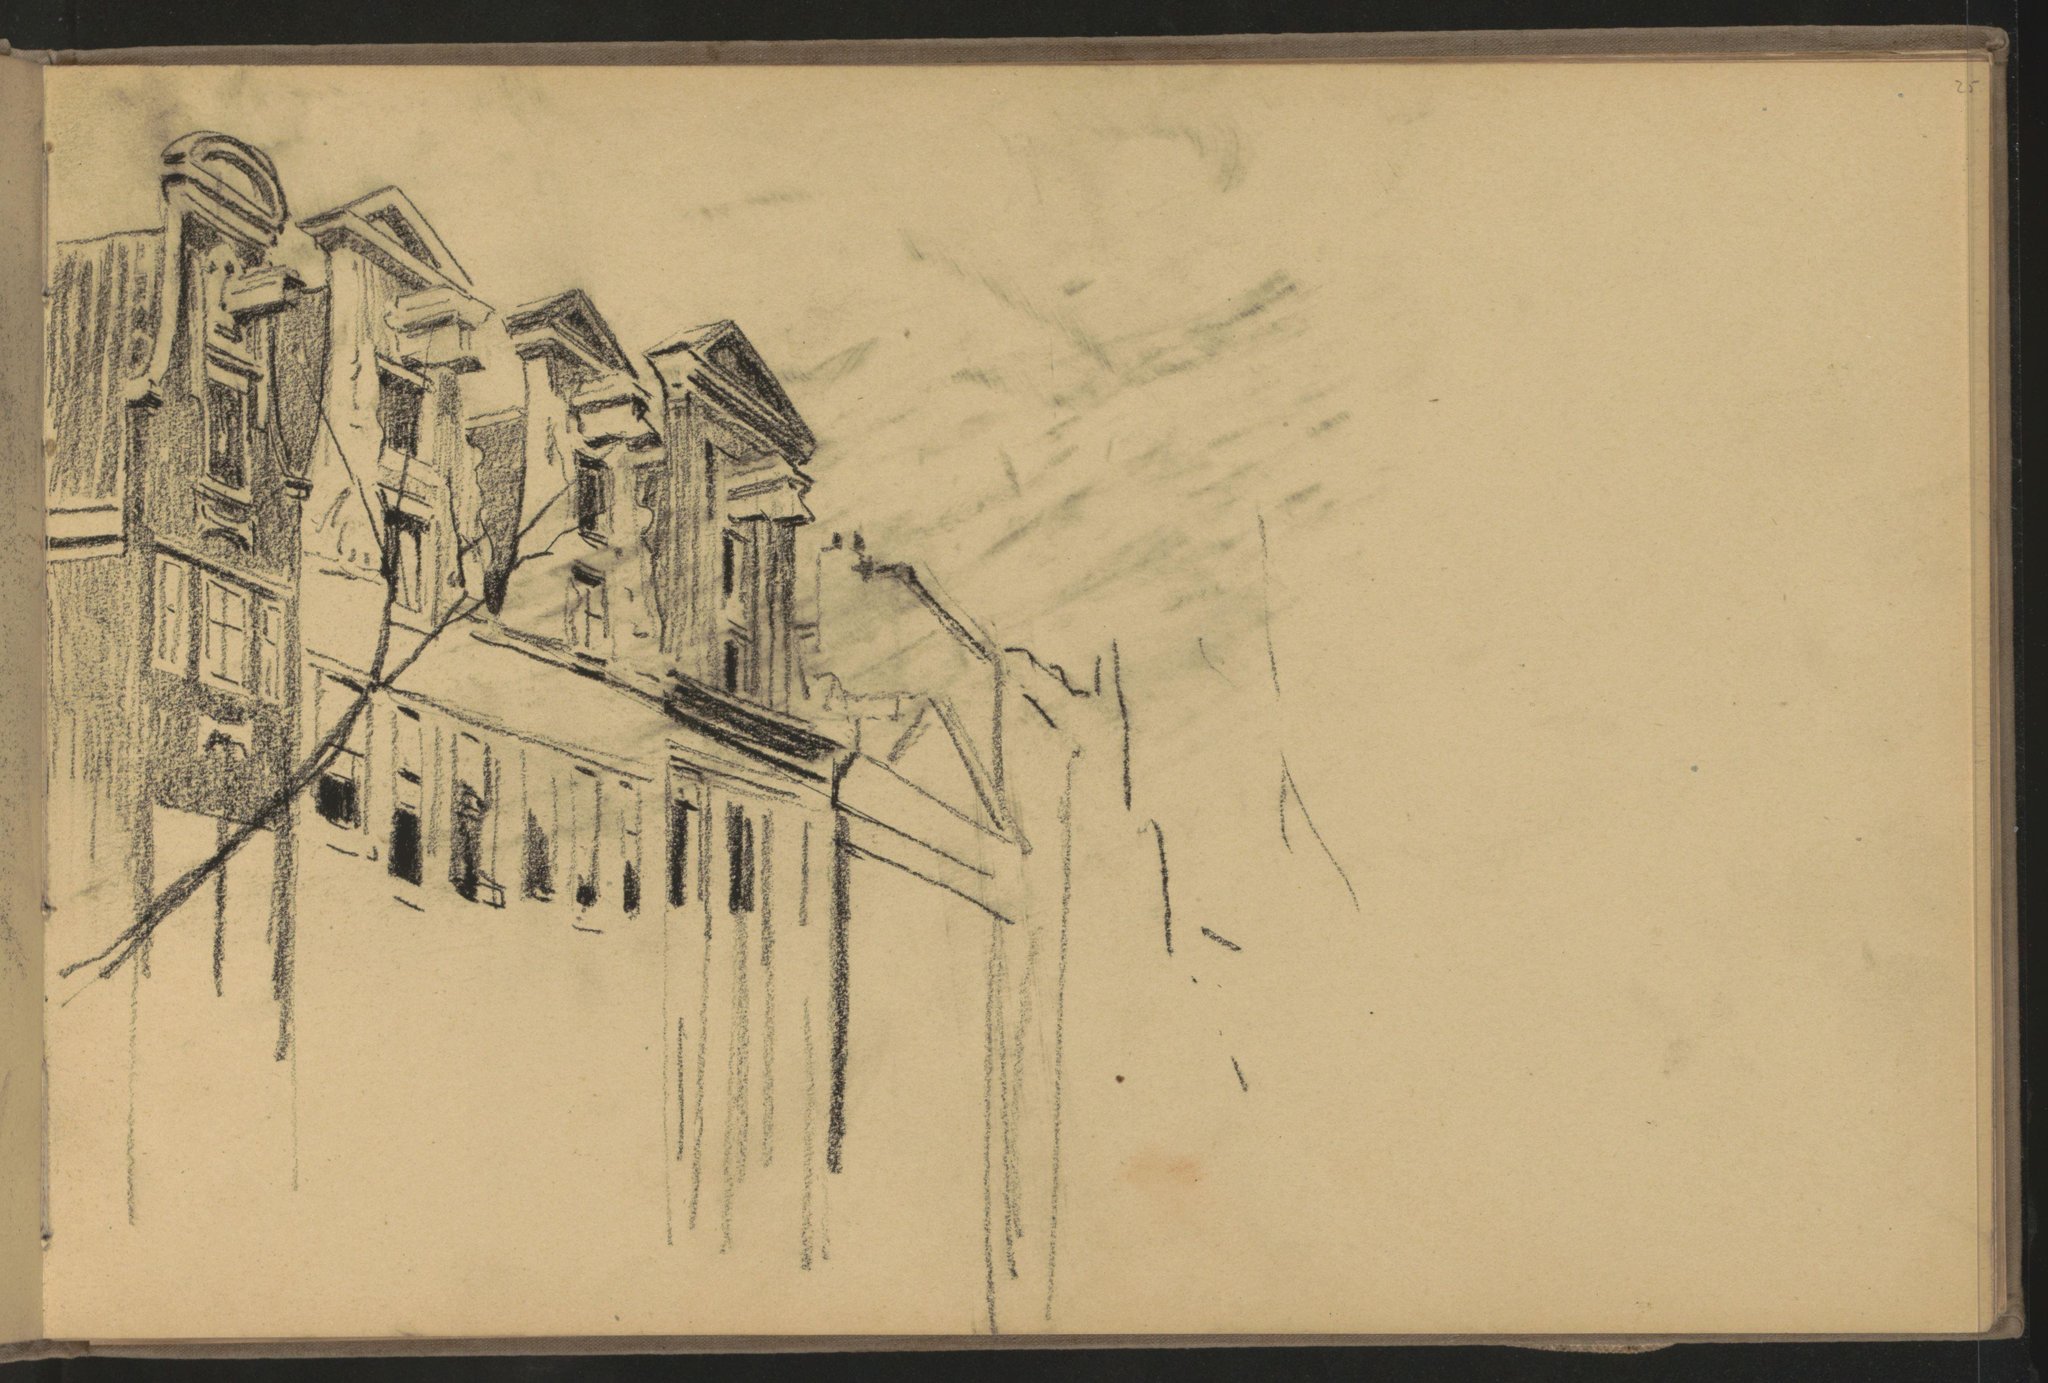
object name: sketchbook leaf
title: Gezicht op de gevels van Herengracht 392-384 te Amsterdam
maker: willem witsen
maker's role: draughtsman, painter, print maker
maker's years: 1860-1923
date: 1901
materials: chalk, paper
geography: amsterdam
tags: front façade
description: Voorstudie voor de ets 'Herengracht', ca. 1901.